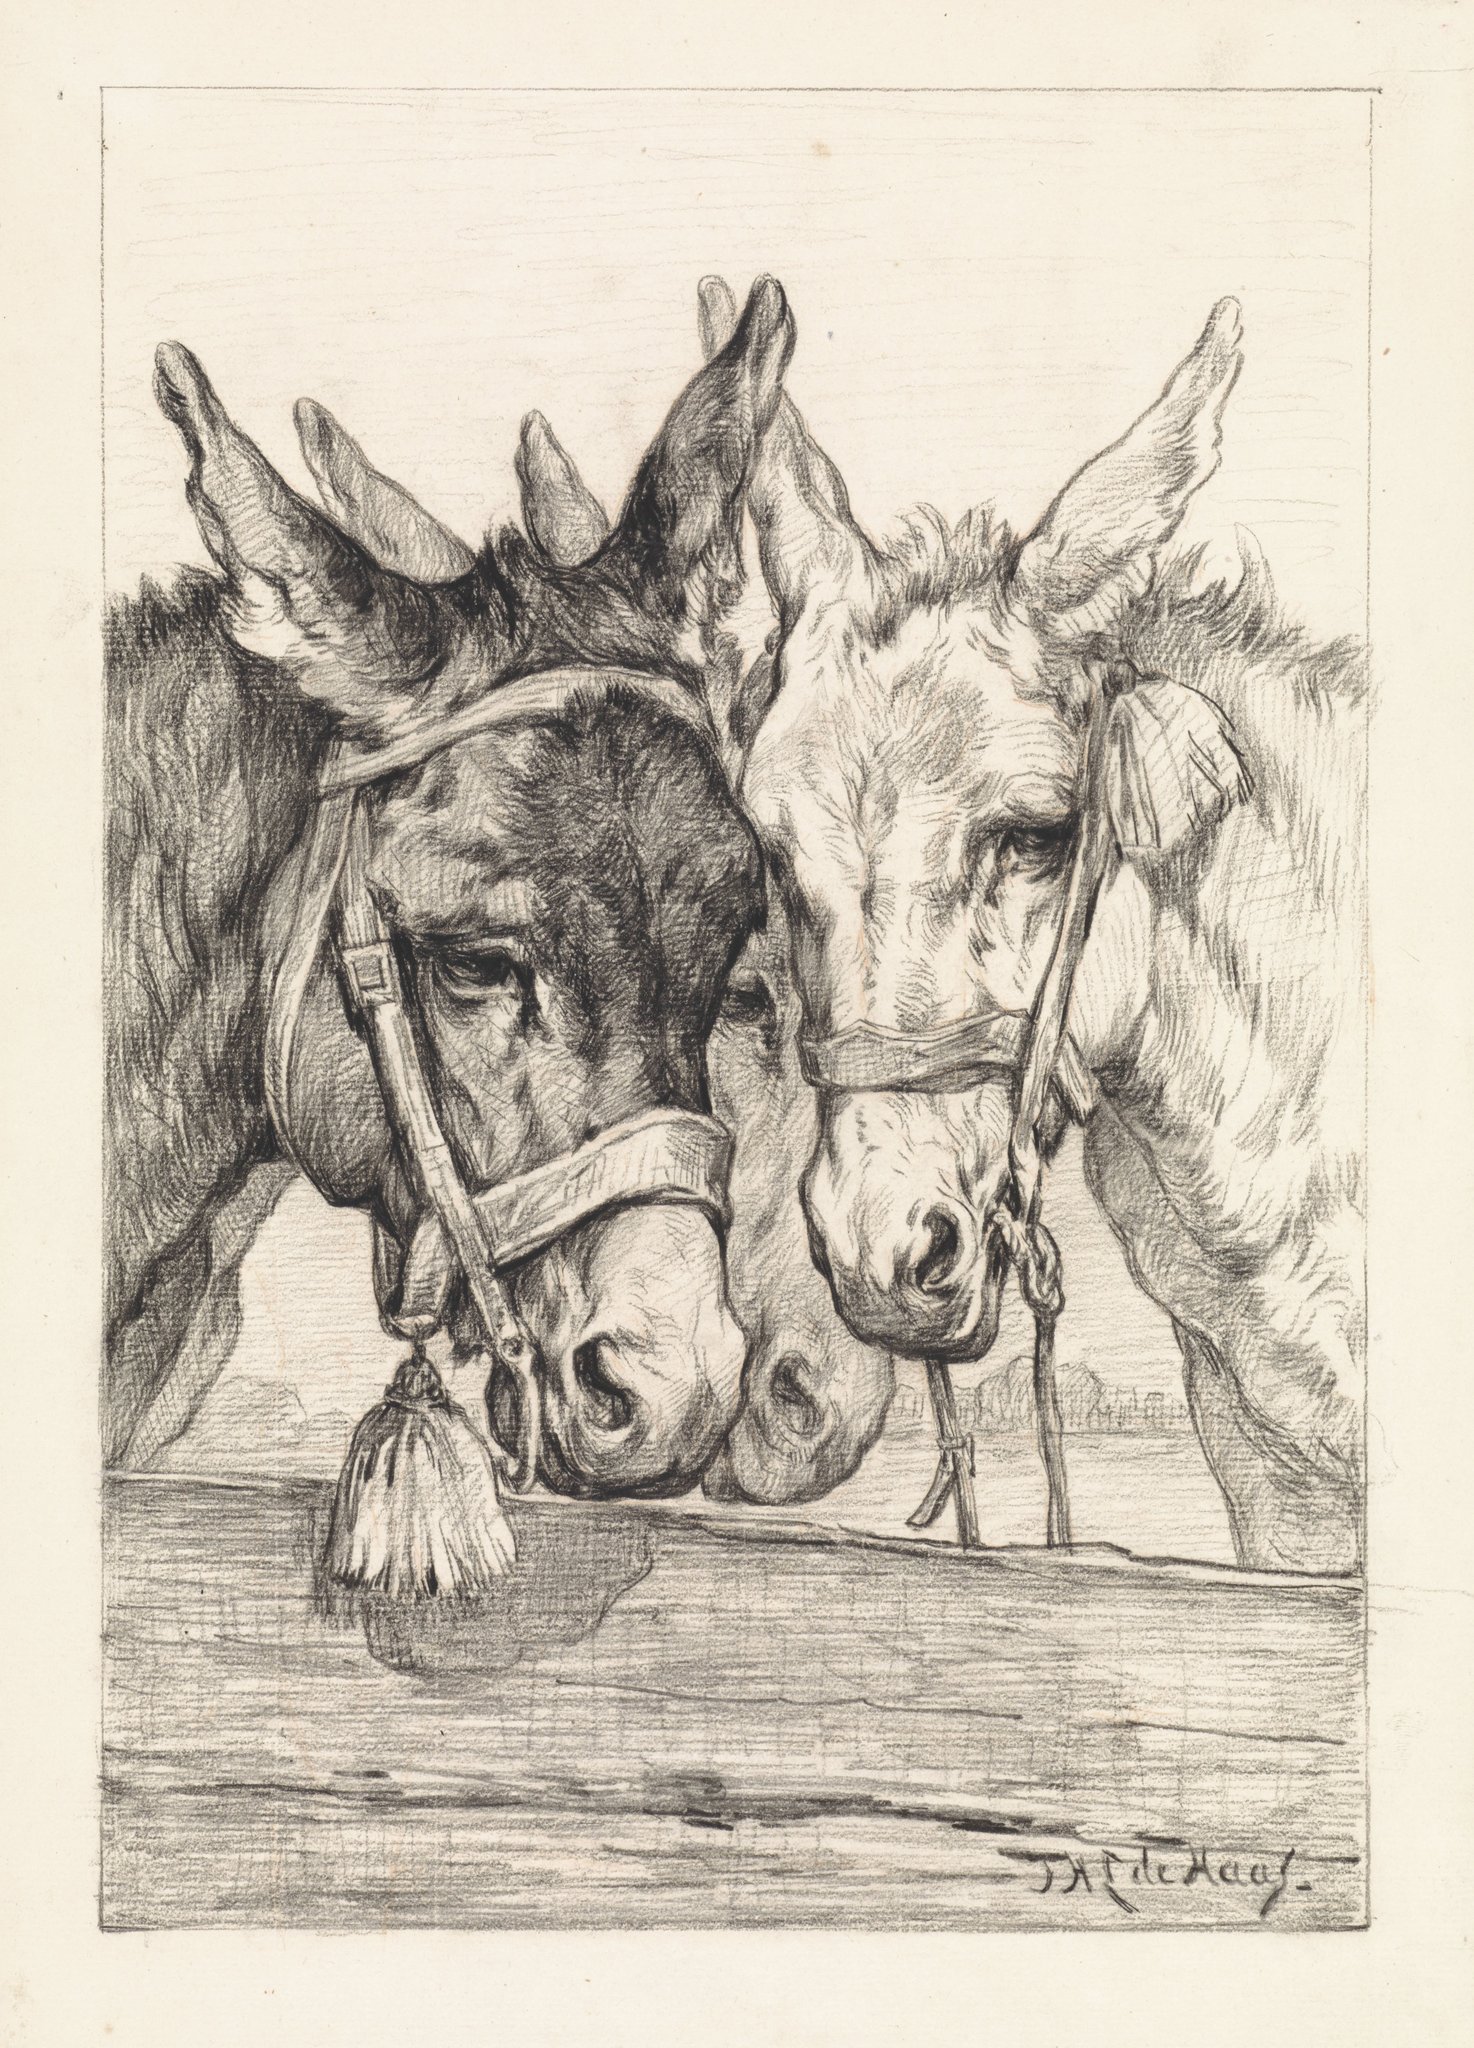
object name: drawing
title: Drie ezels achter een schutting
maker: johannes hubertus leonardus de haas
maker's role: draughtsman, painter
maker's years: 1832-1908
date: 1842-1883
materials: chalk, paper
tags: ass, donkey